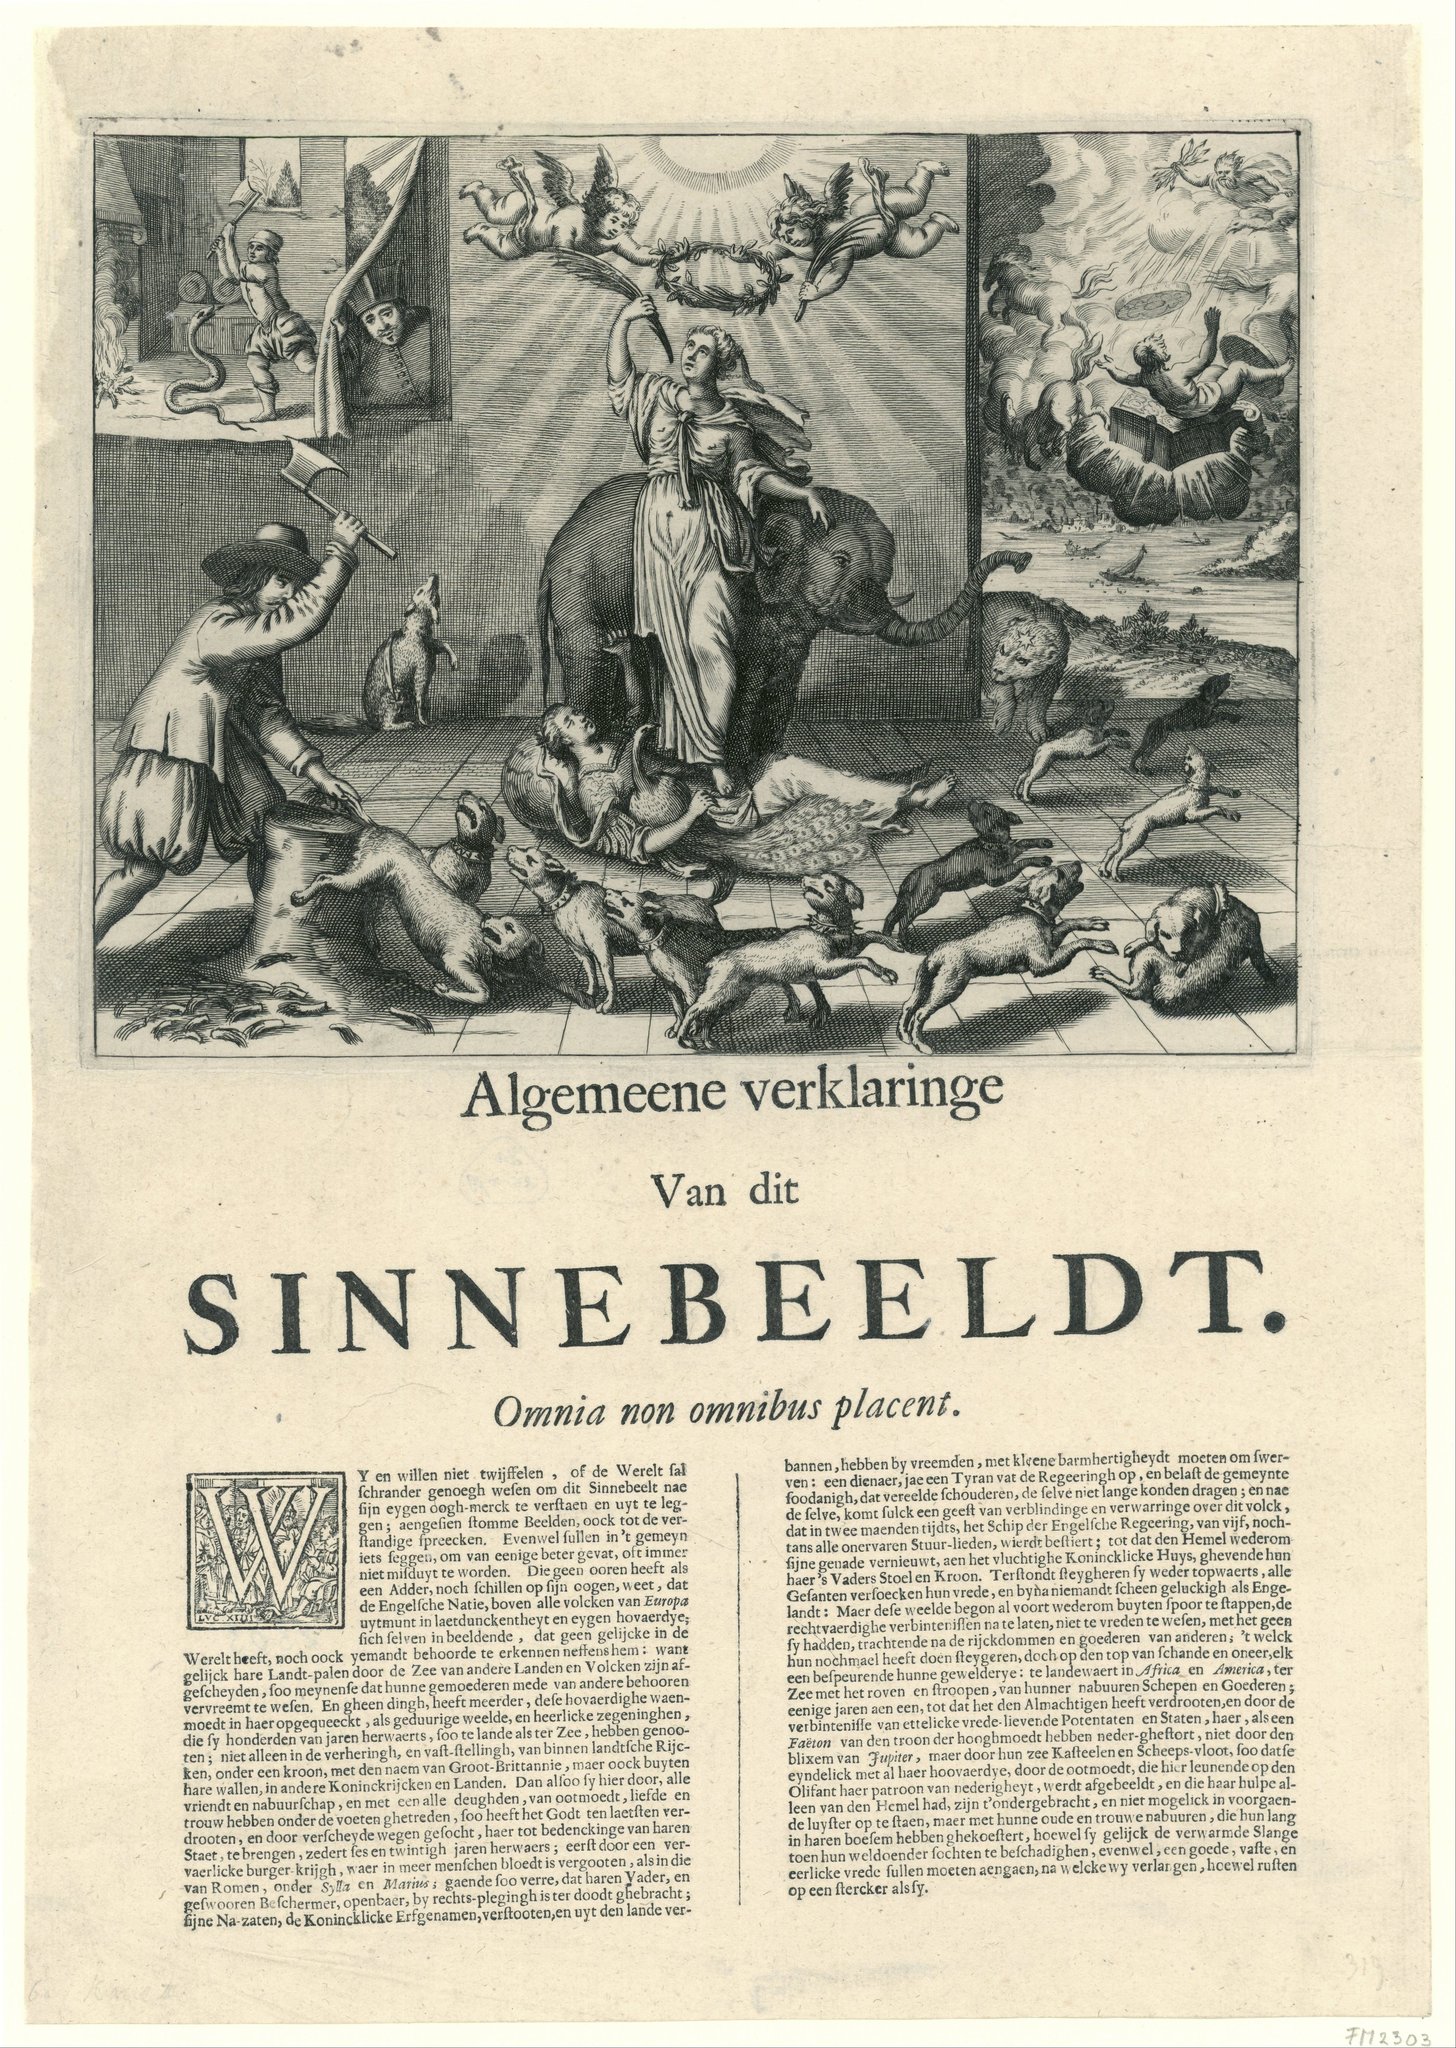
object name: cartoon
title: Spotprent op de Engelsen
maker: Anonymous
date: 1668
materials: paper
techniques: engraving, letterpress printing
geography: northern netherlands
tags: political caricatures and satires, netherlands, england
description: Zinnebeeld op de ondankbaarheid van de Engelsen aan de vooravond van de Derde Engelse Oorlog. Allegorische voorstelling met de Nederlandse Maagd en een Hollandse matroos die de staarten van de Engelse doggen afhakken. Onder de voorstelling de 'Algemeene verklaringe van dit Sinnebeeldt. Omnia non omnibus placent.' De prent is gekopieerd en opgenomen in 'A Justification of the Present War against the United Netherlands' van Henry Stubbs, uitgegeven in 1672 te Londen.